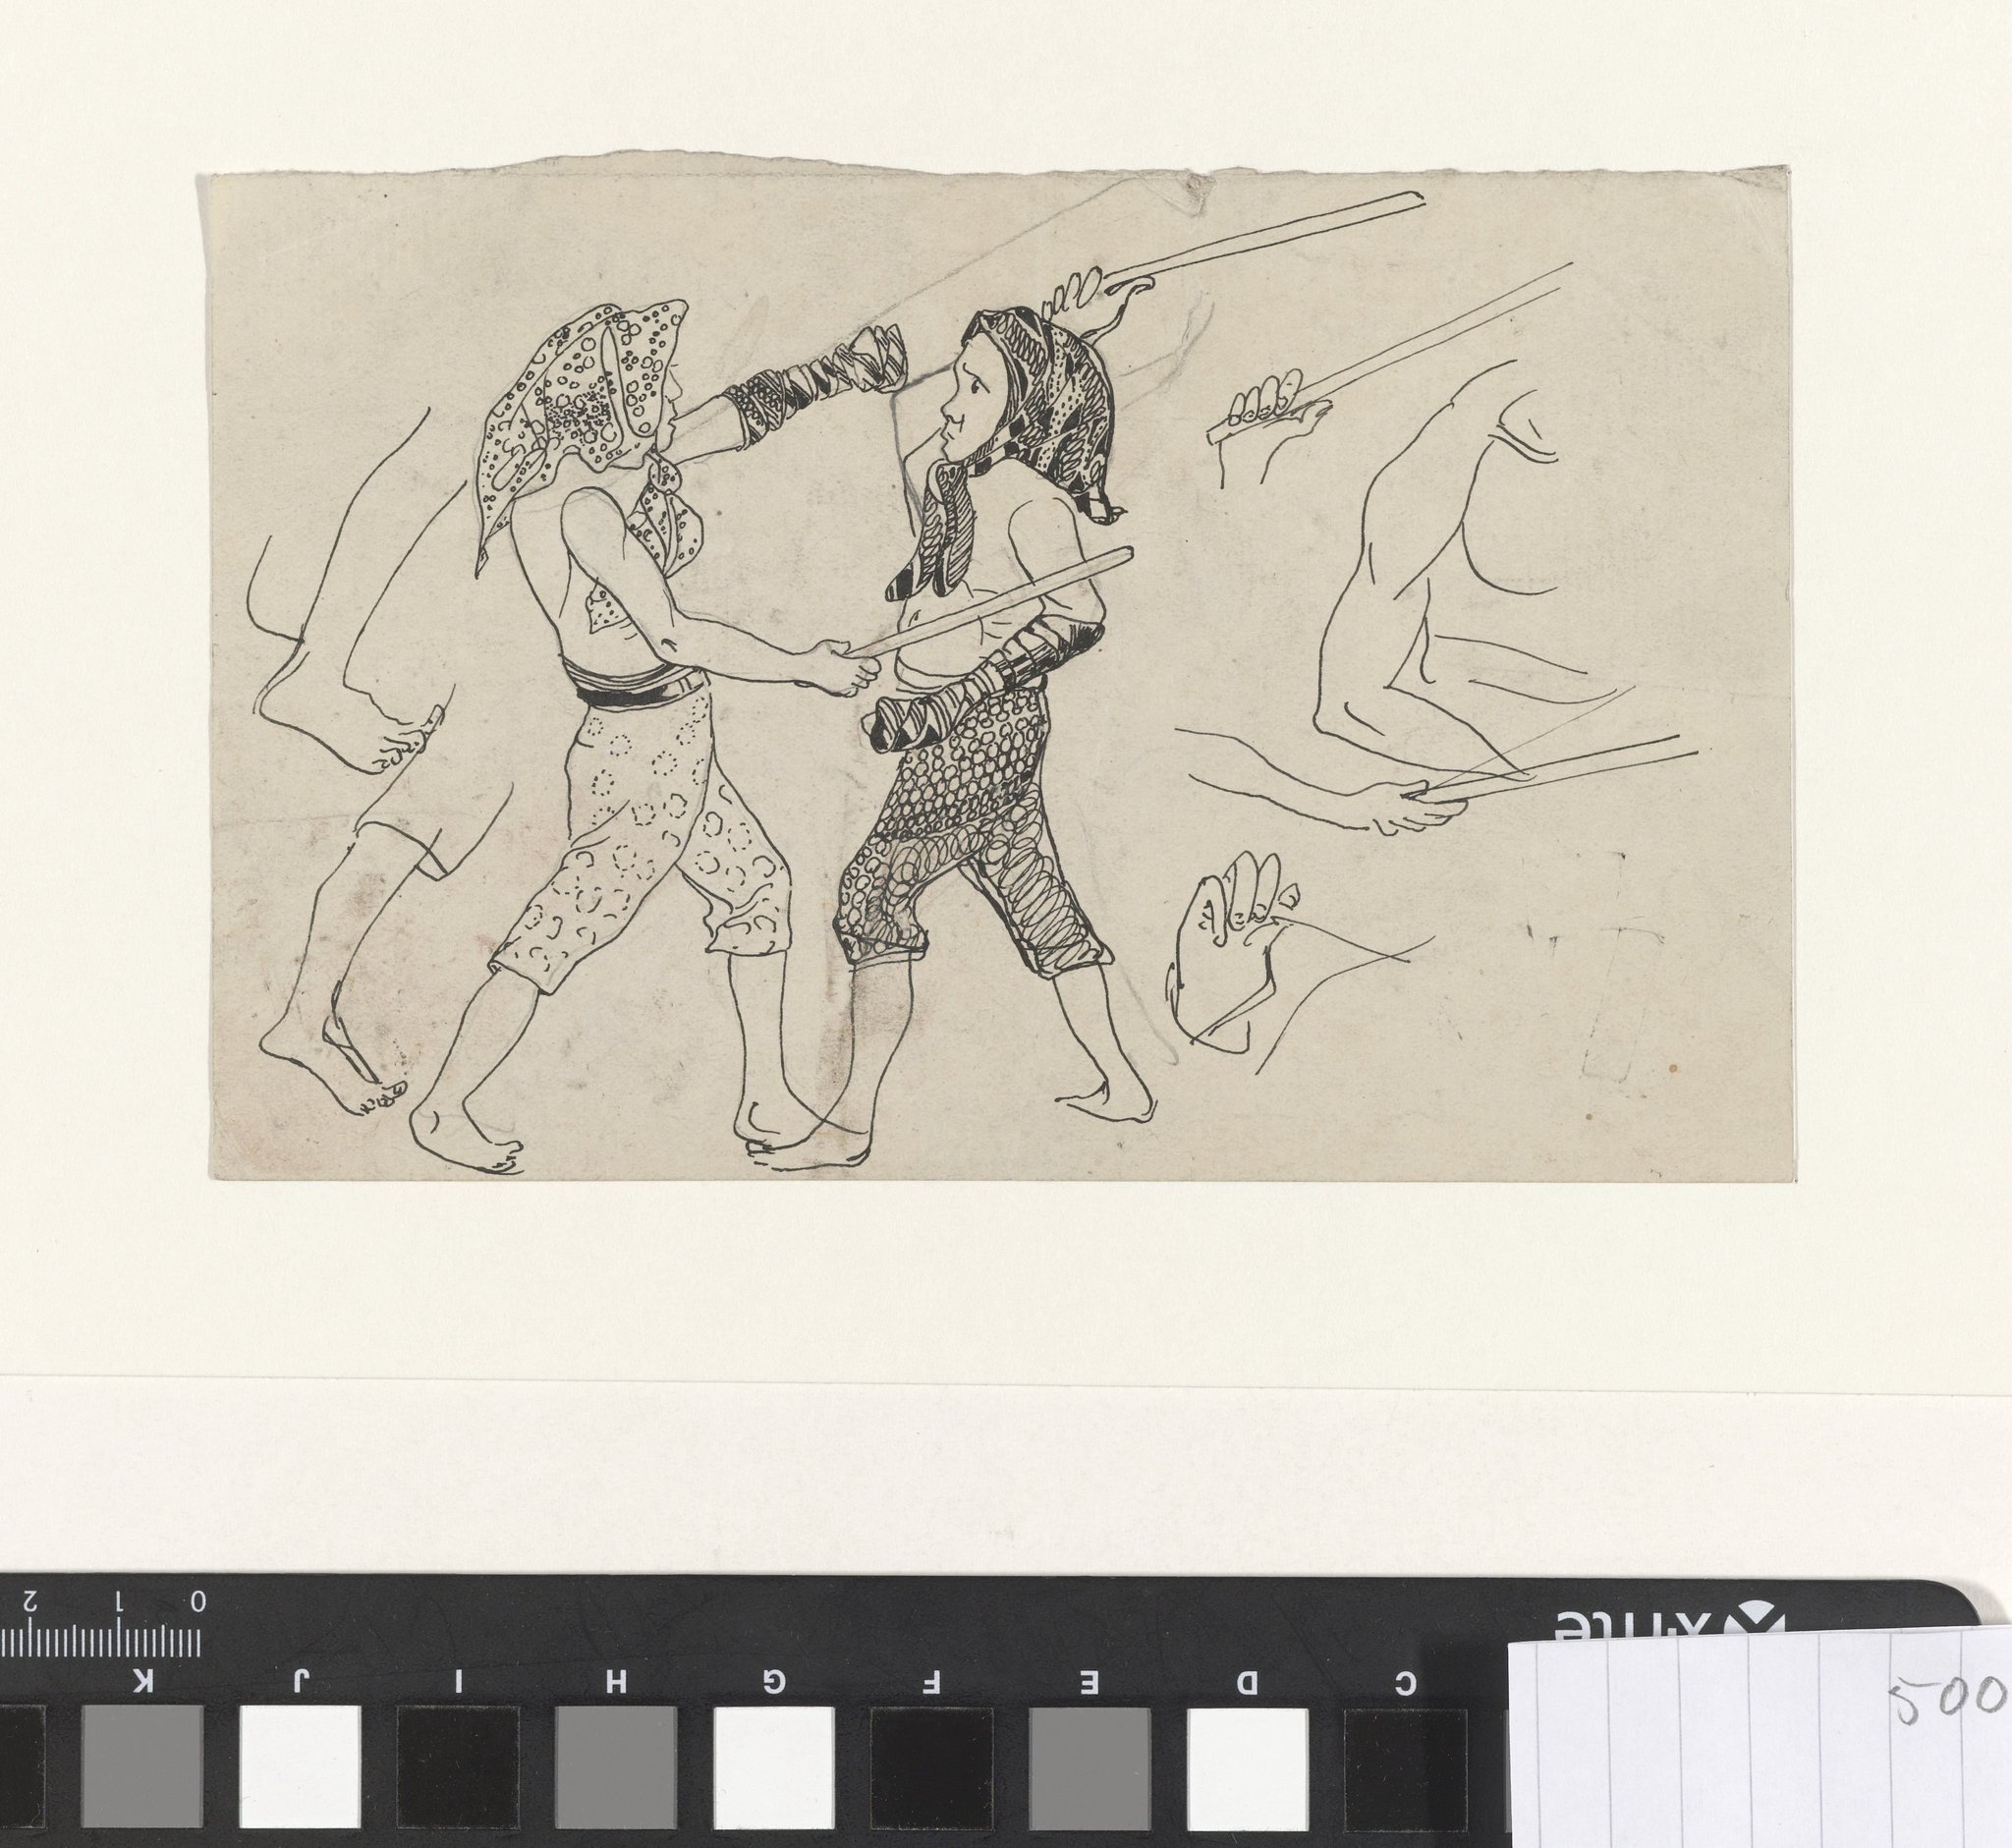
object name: drawing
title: Twee stokvechters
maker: carel adolph lion cachet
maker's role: draughtsman, print maker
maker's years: 1864-1945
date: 1874-1945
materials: ink, paper, pencil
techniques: pen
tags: jiu-jitsu, judo, etc.